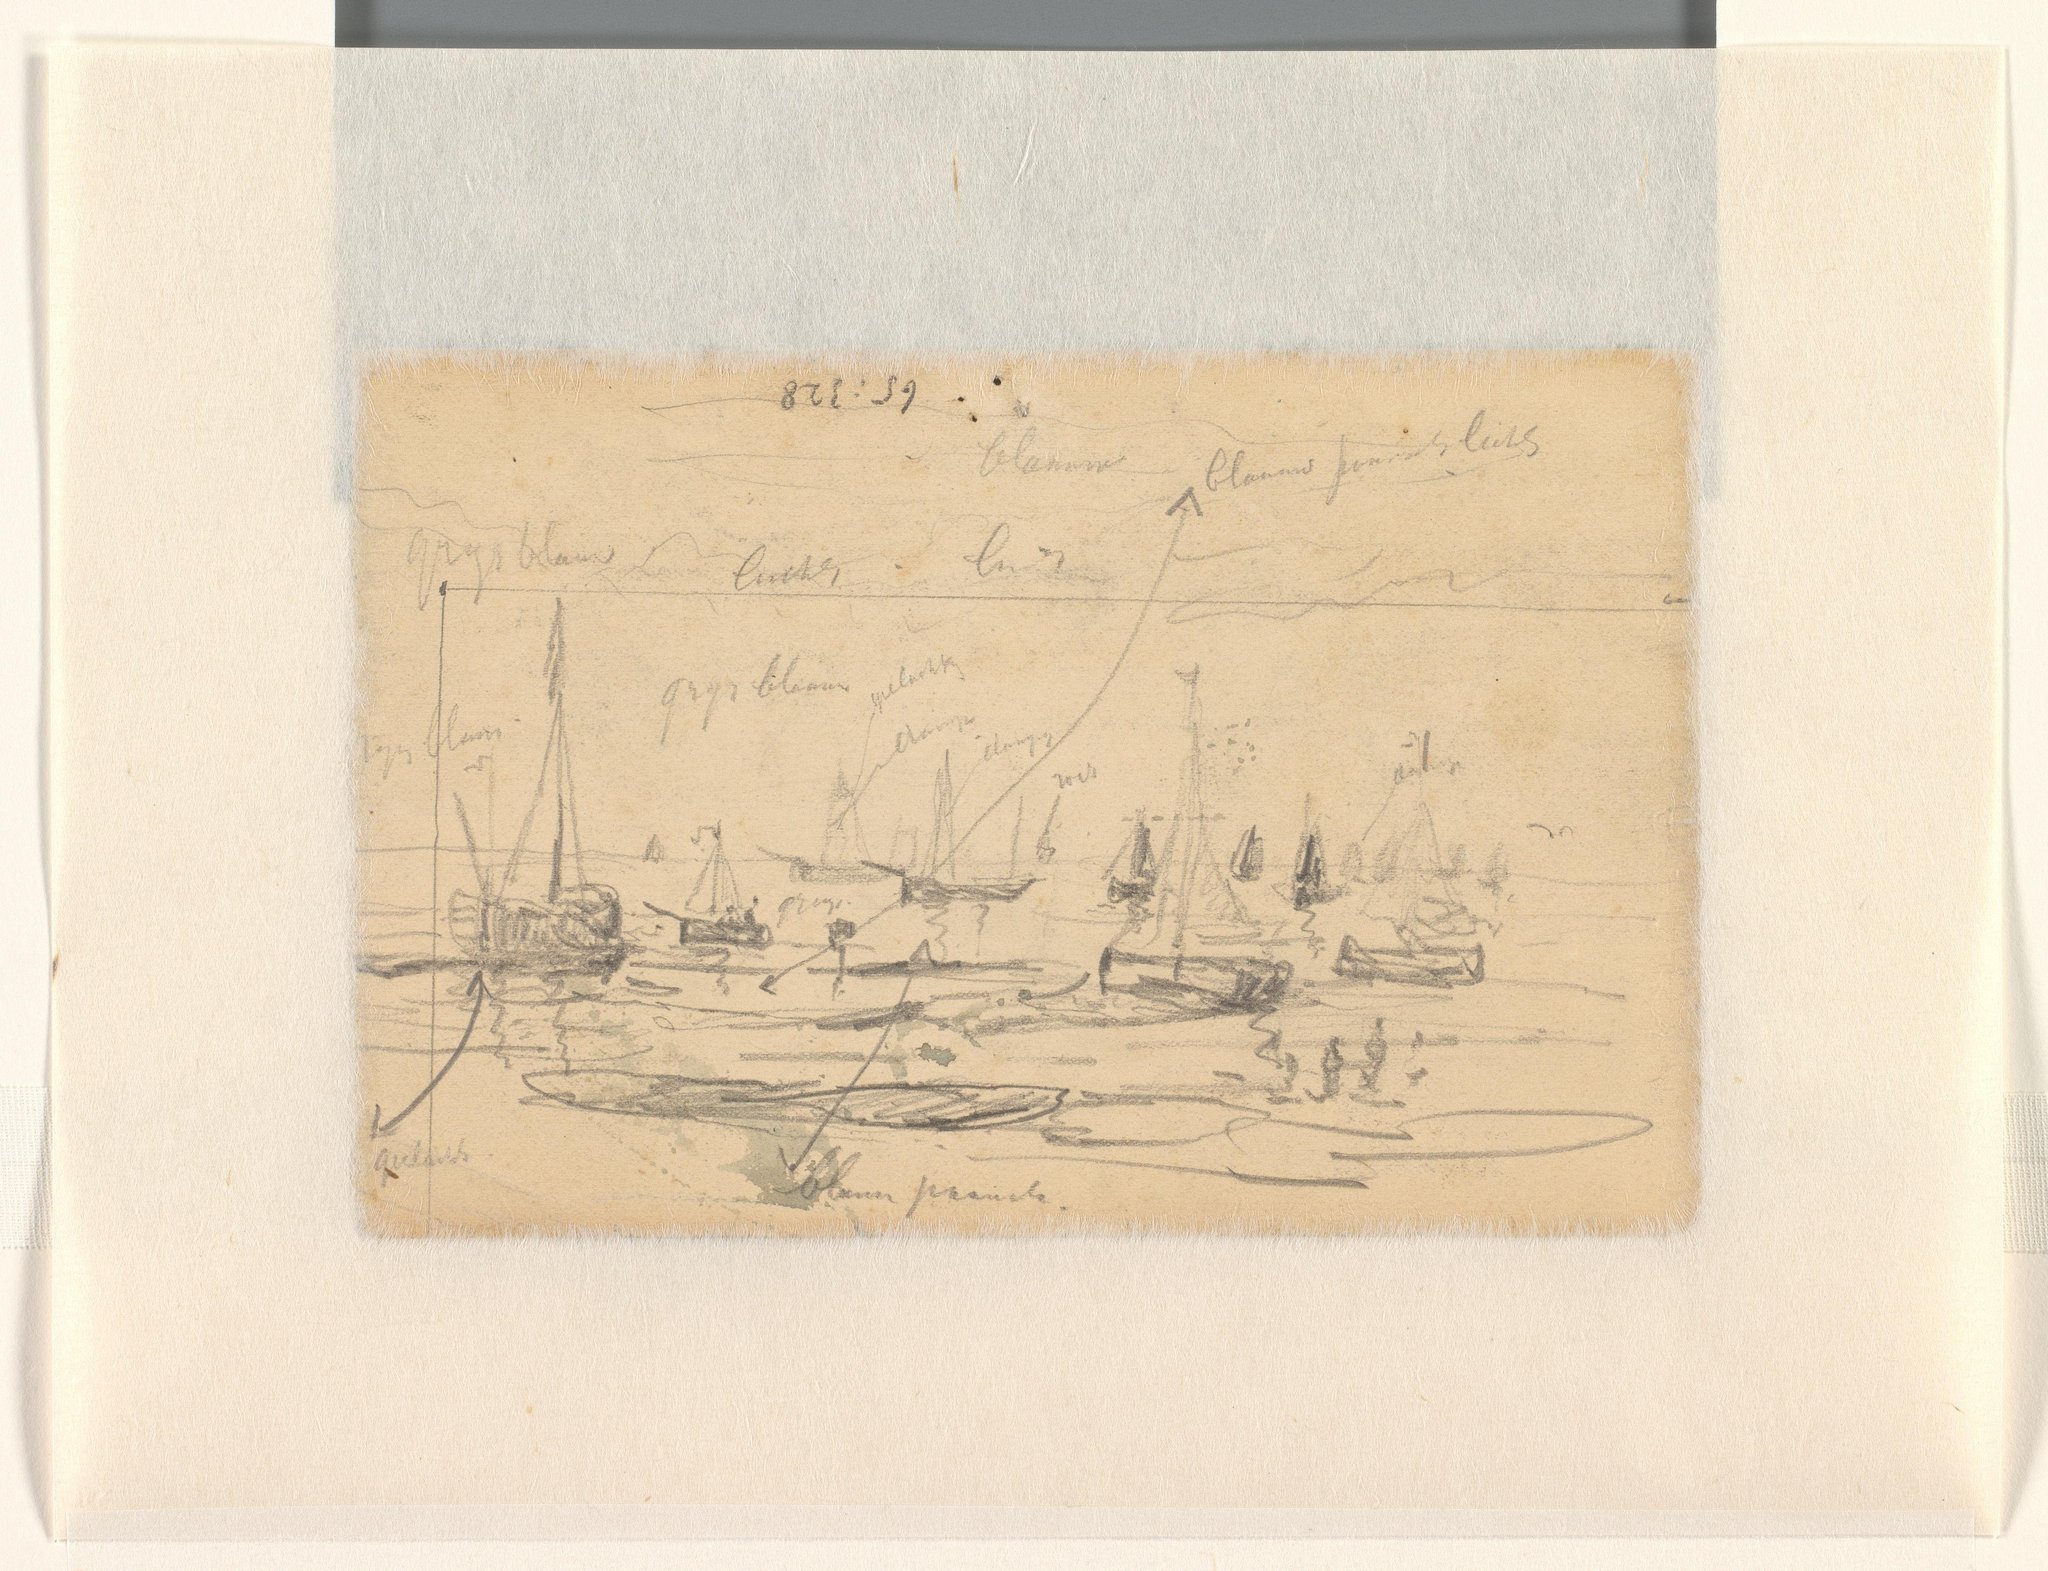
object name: drawing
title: Zeegezicht met vissersboten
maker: johannes huygens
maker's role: draughtsman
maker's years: 1833-1911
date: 1843-1911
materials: paper, pencil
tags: sailing-ship, sailing-boat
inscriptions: kleurnotitie, handgeschreven